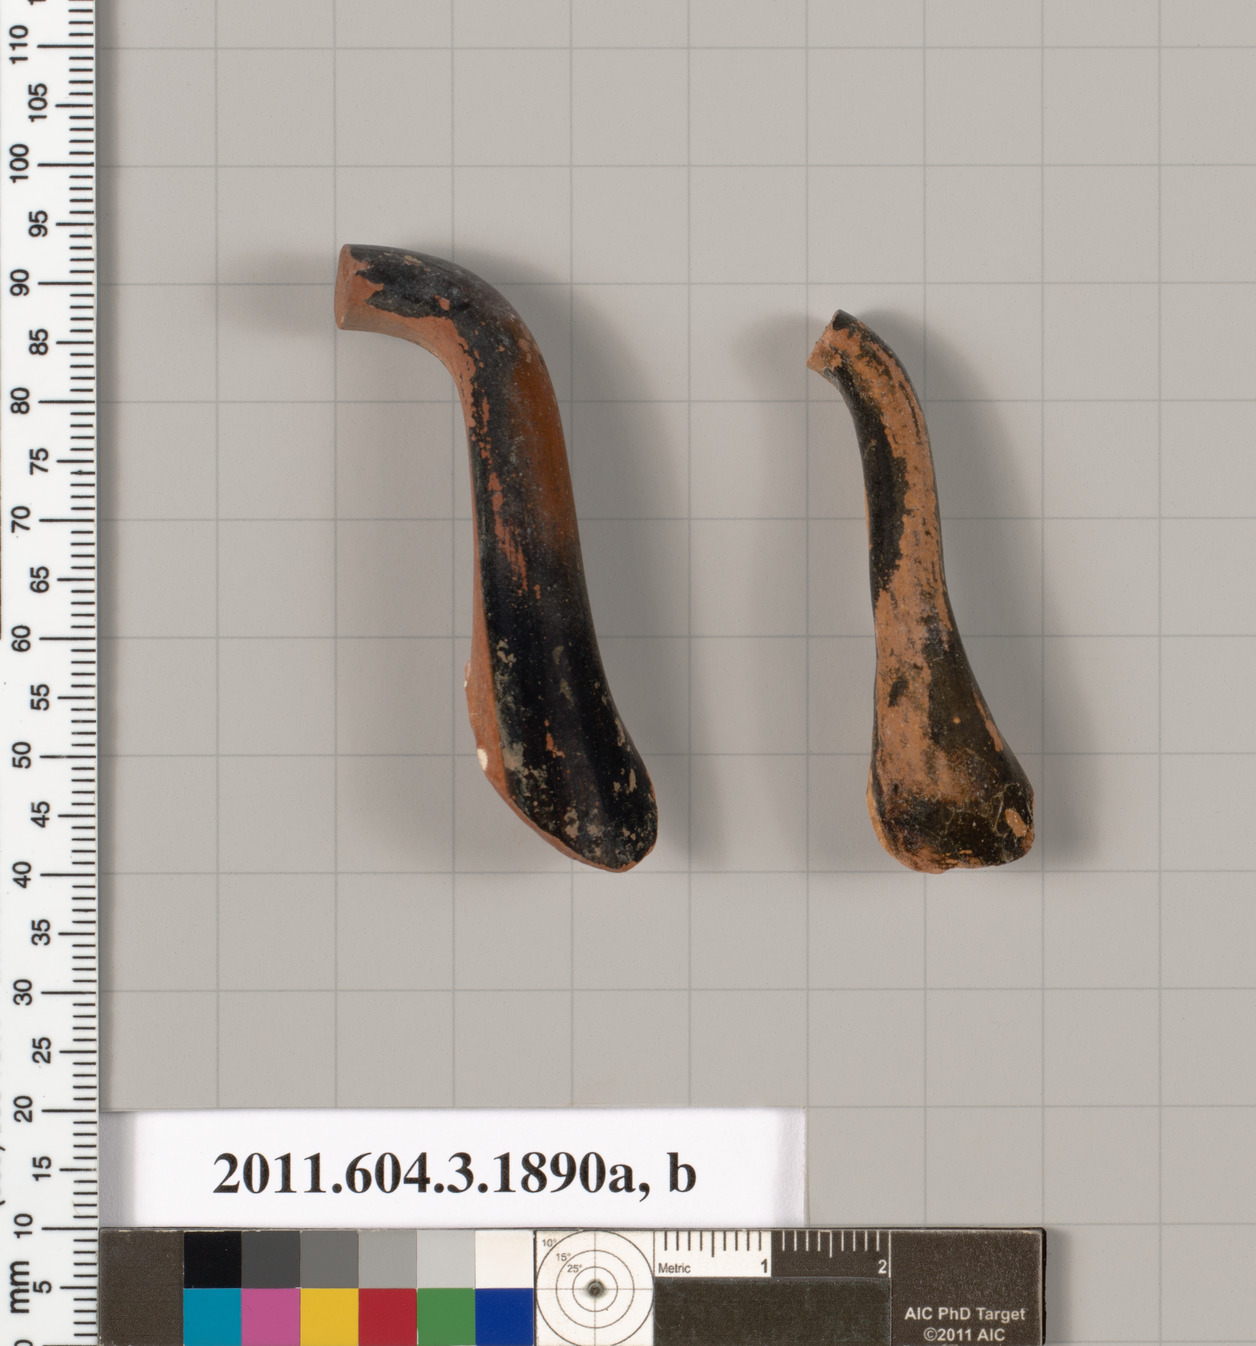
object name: kylix or skyphos fragment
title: Terracotta fragments of a kylix (drinking cup) or a skyphos (deep drinking cup)?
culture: greek, attic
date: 600-401 BCE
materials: terracotta